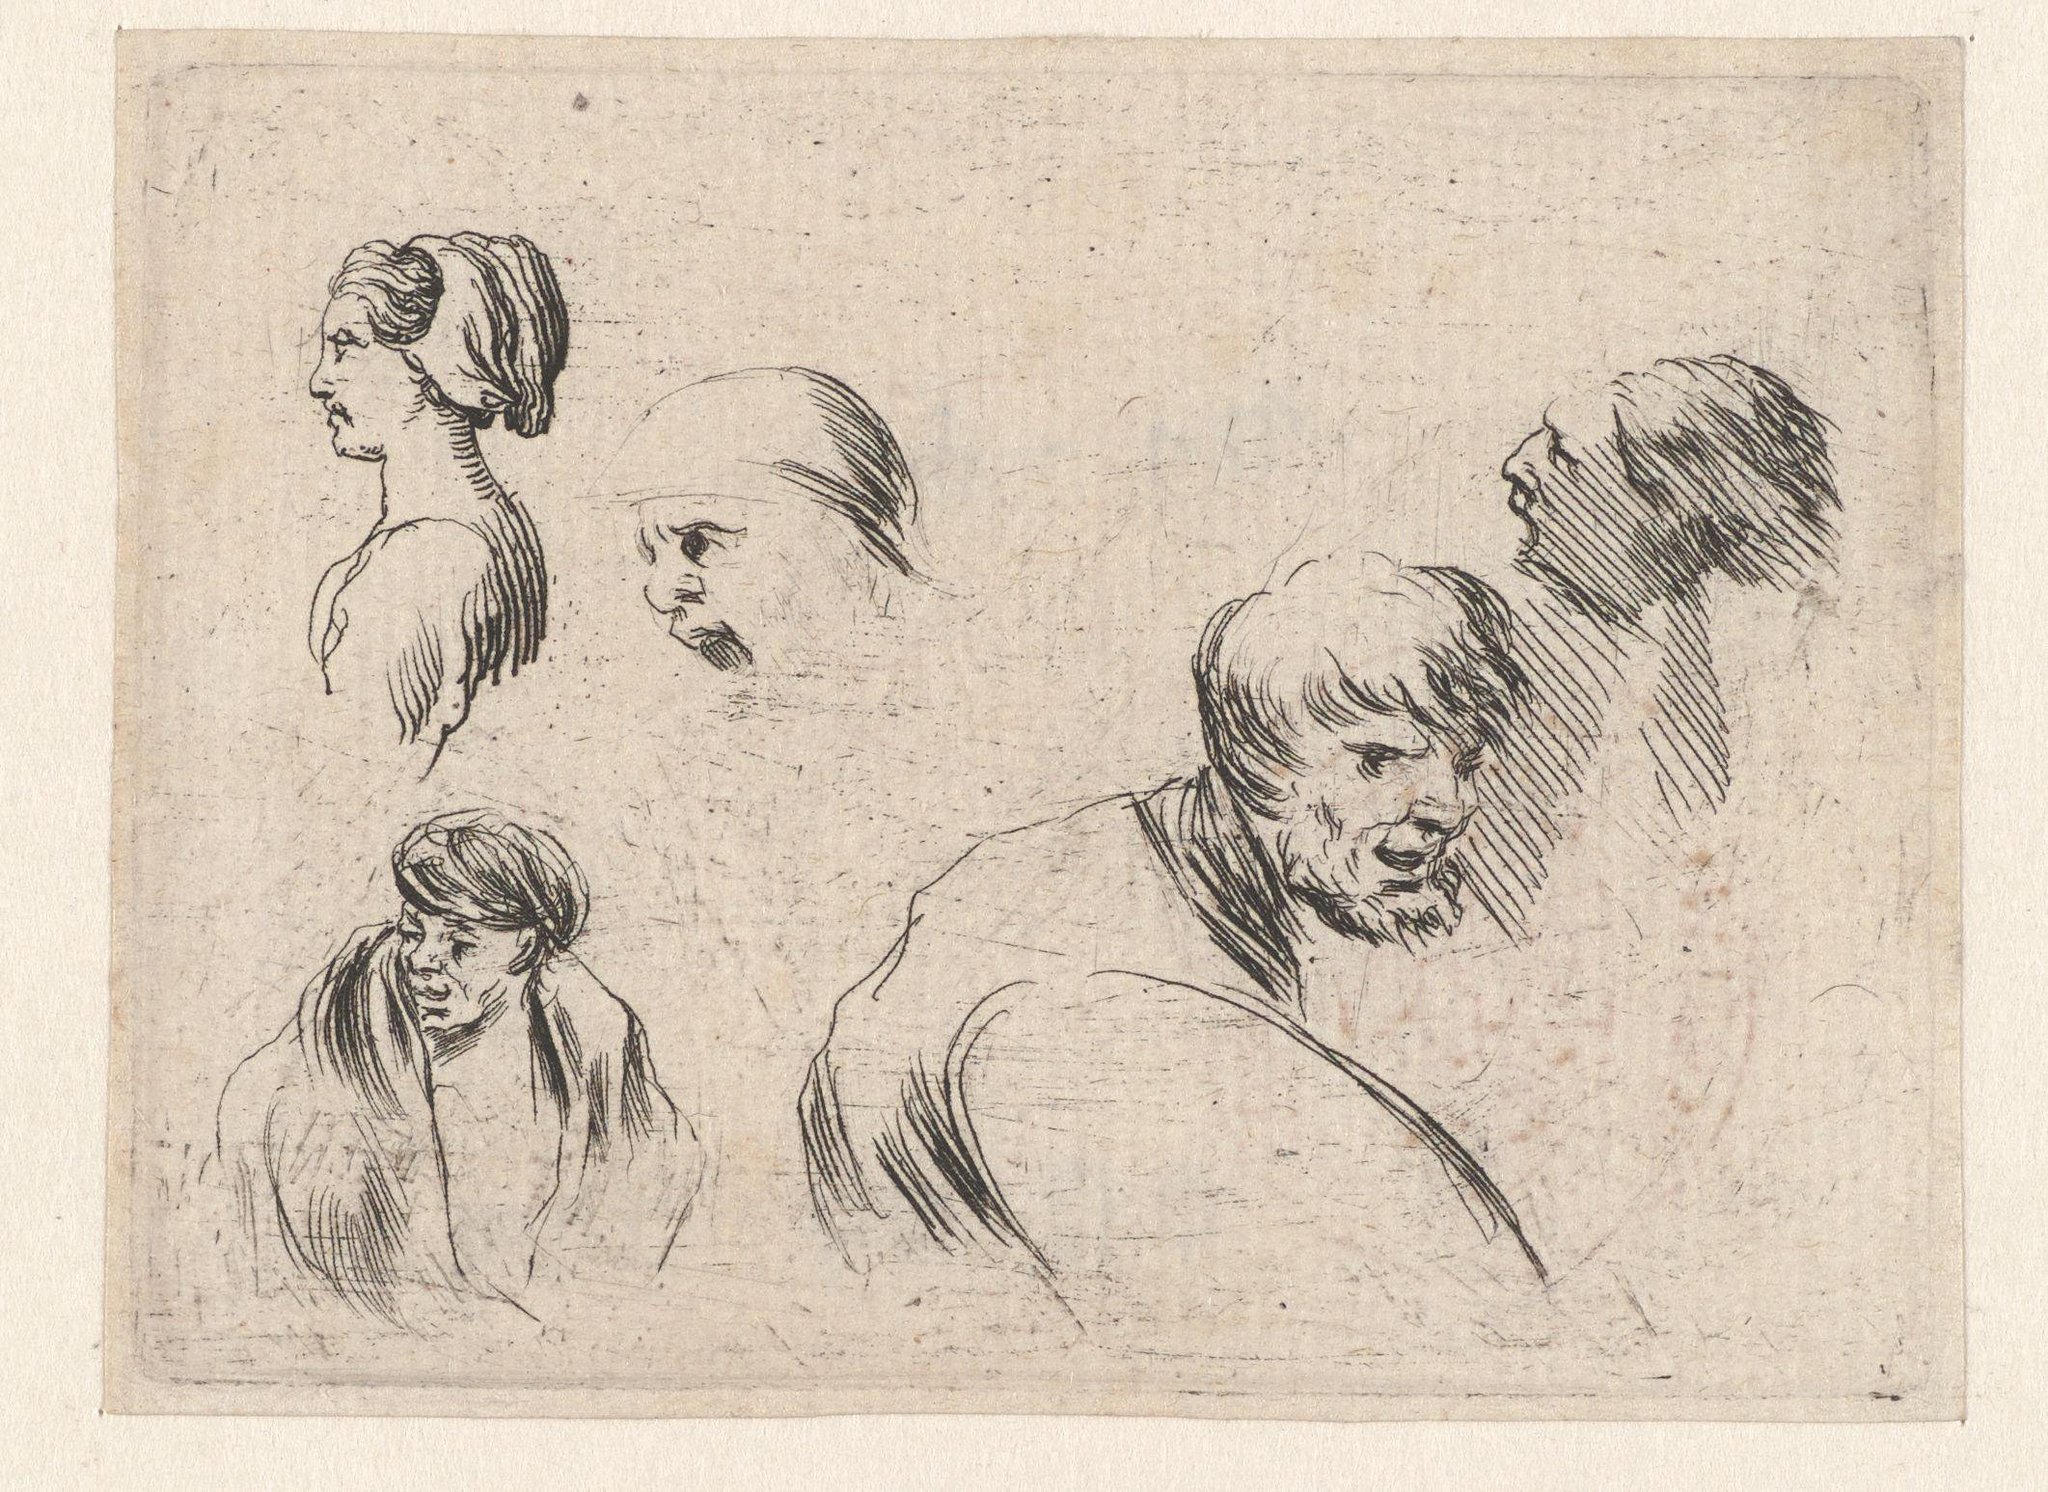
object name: print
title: Recueil de divers griffonnements & preuves d'eau forte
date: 1620-1657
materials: paper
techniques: etching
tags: head (human) (+ sideview, profile), human types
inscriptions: collector's mark: Lugt 240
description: Vier hoofden naar links gewend en één hoofd naar rechts gewend.